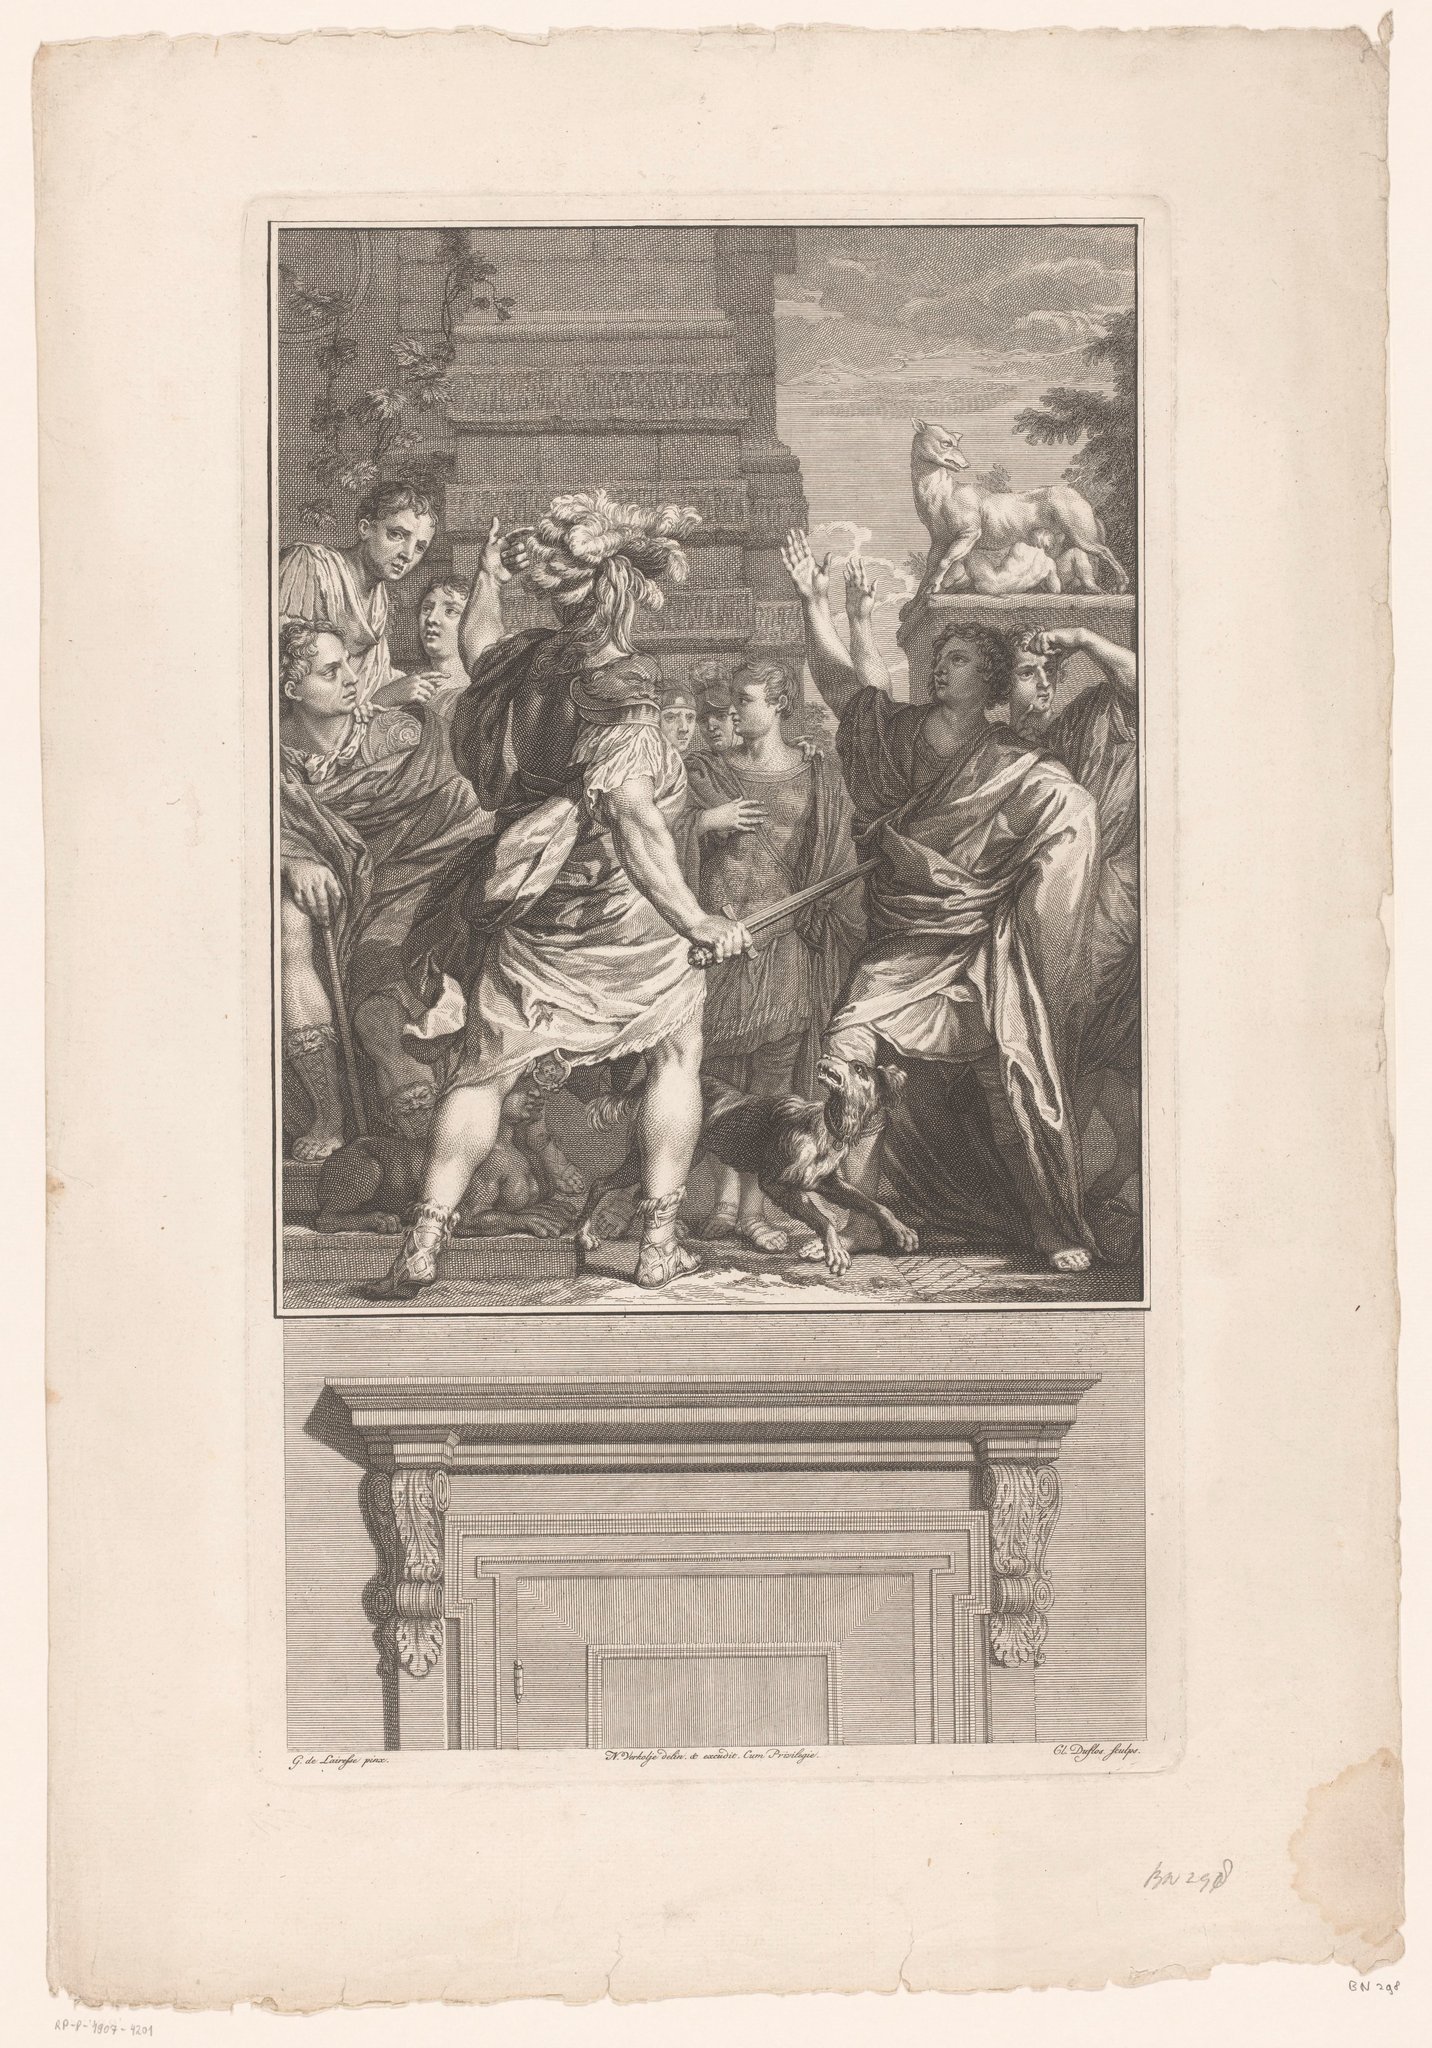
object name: print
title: Prenten naar schilderijen in de raadszaal van het gerechtshof in Den Haag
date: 1683-1727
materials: paper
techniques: engraving, etching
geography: france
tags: non-aggressive activities of scipio africanus major, rome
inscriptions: collector's mark: Lugt 2228